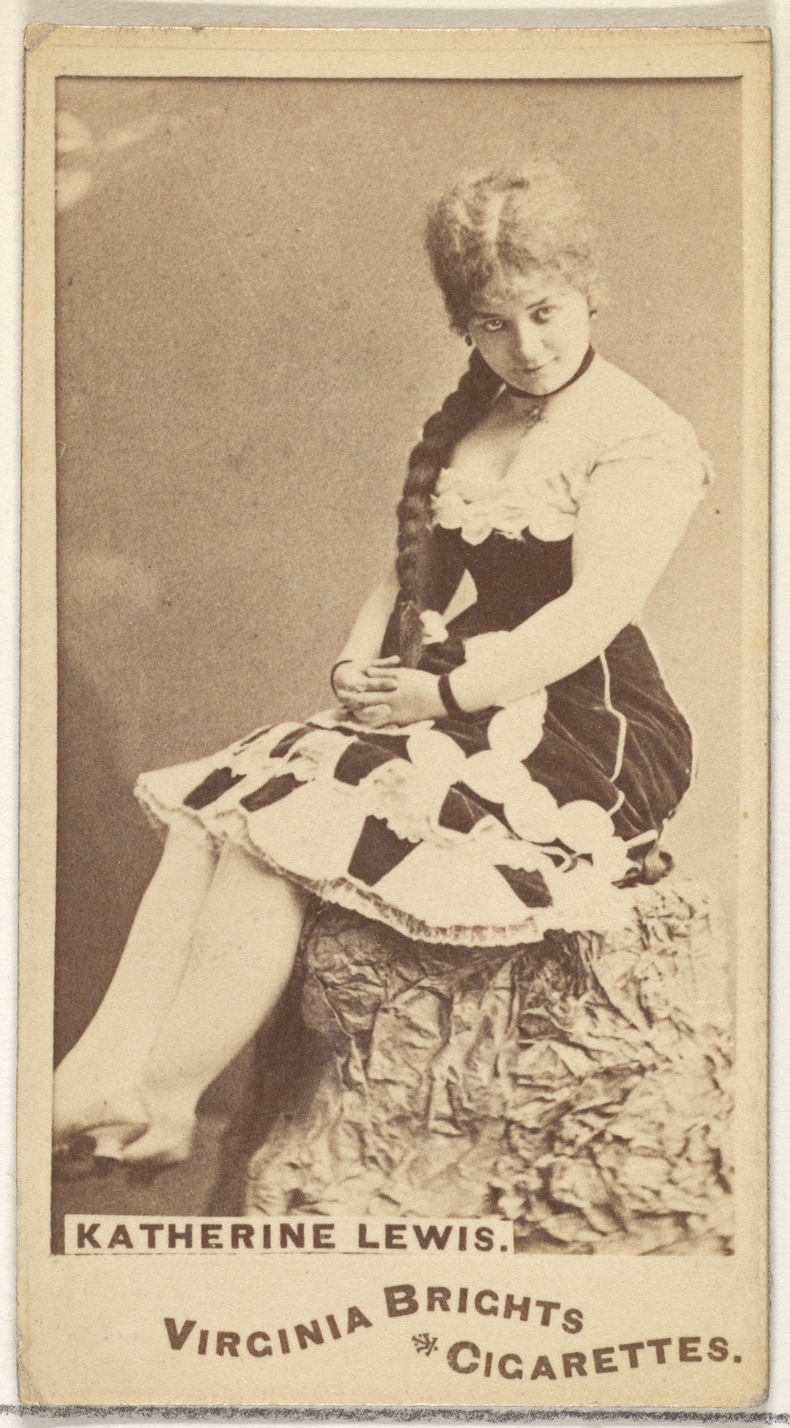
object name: photograph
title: Katherine Lewis, from the Actors and Actresses series (N45, Type 1) for Virginia Brights Cigarettes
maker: allen & ginter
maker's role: publisher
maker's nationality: american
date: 1888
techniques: albumen silver print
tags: portraits,women,actresses